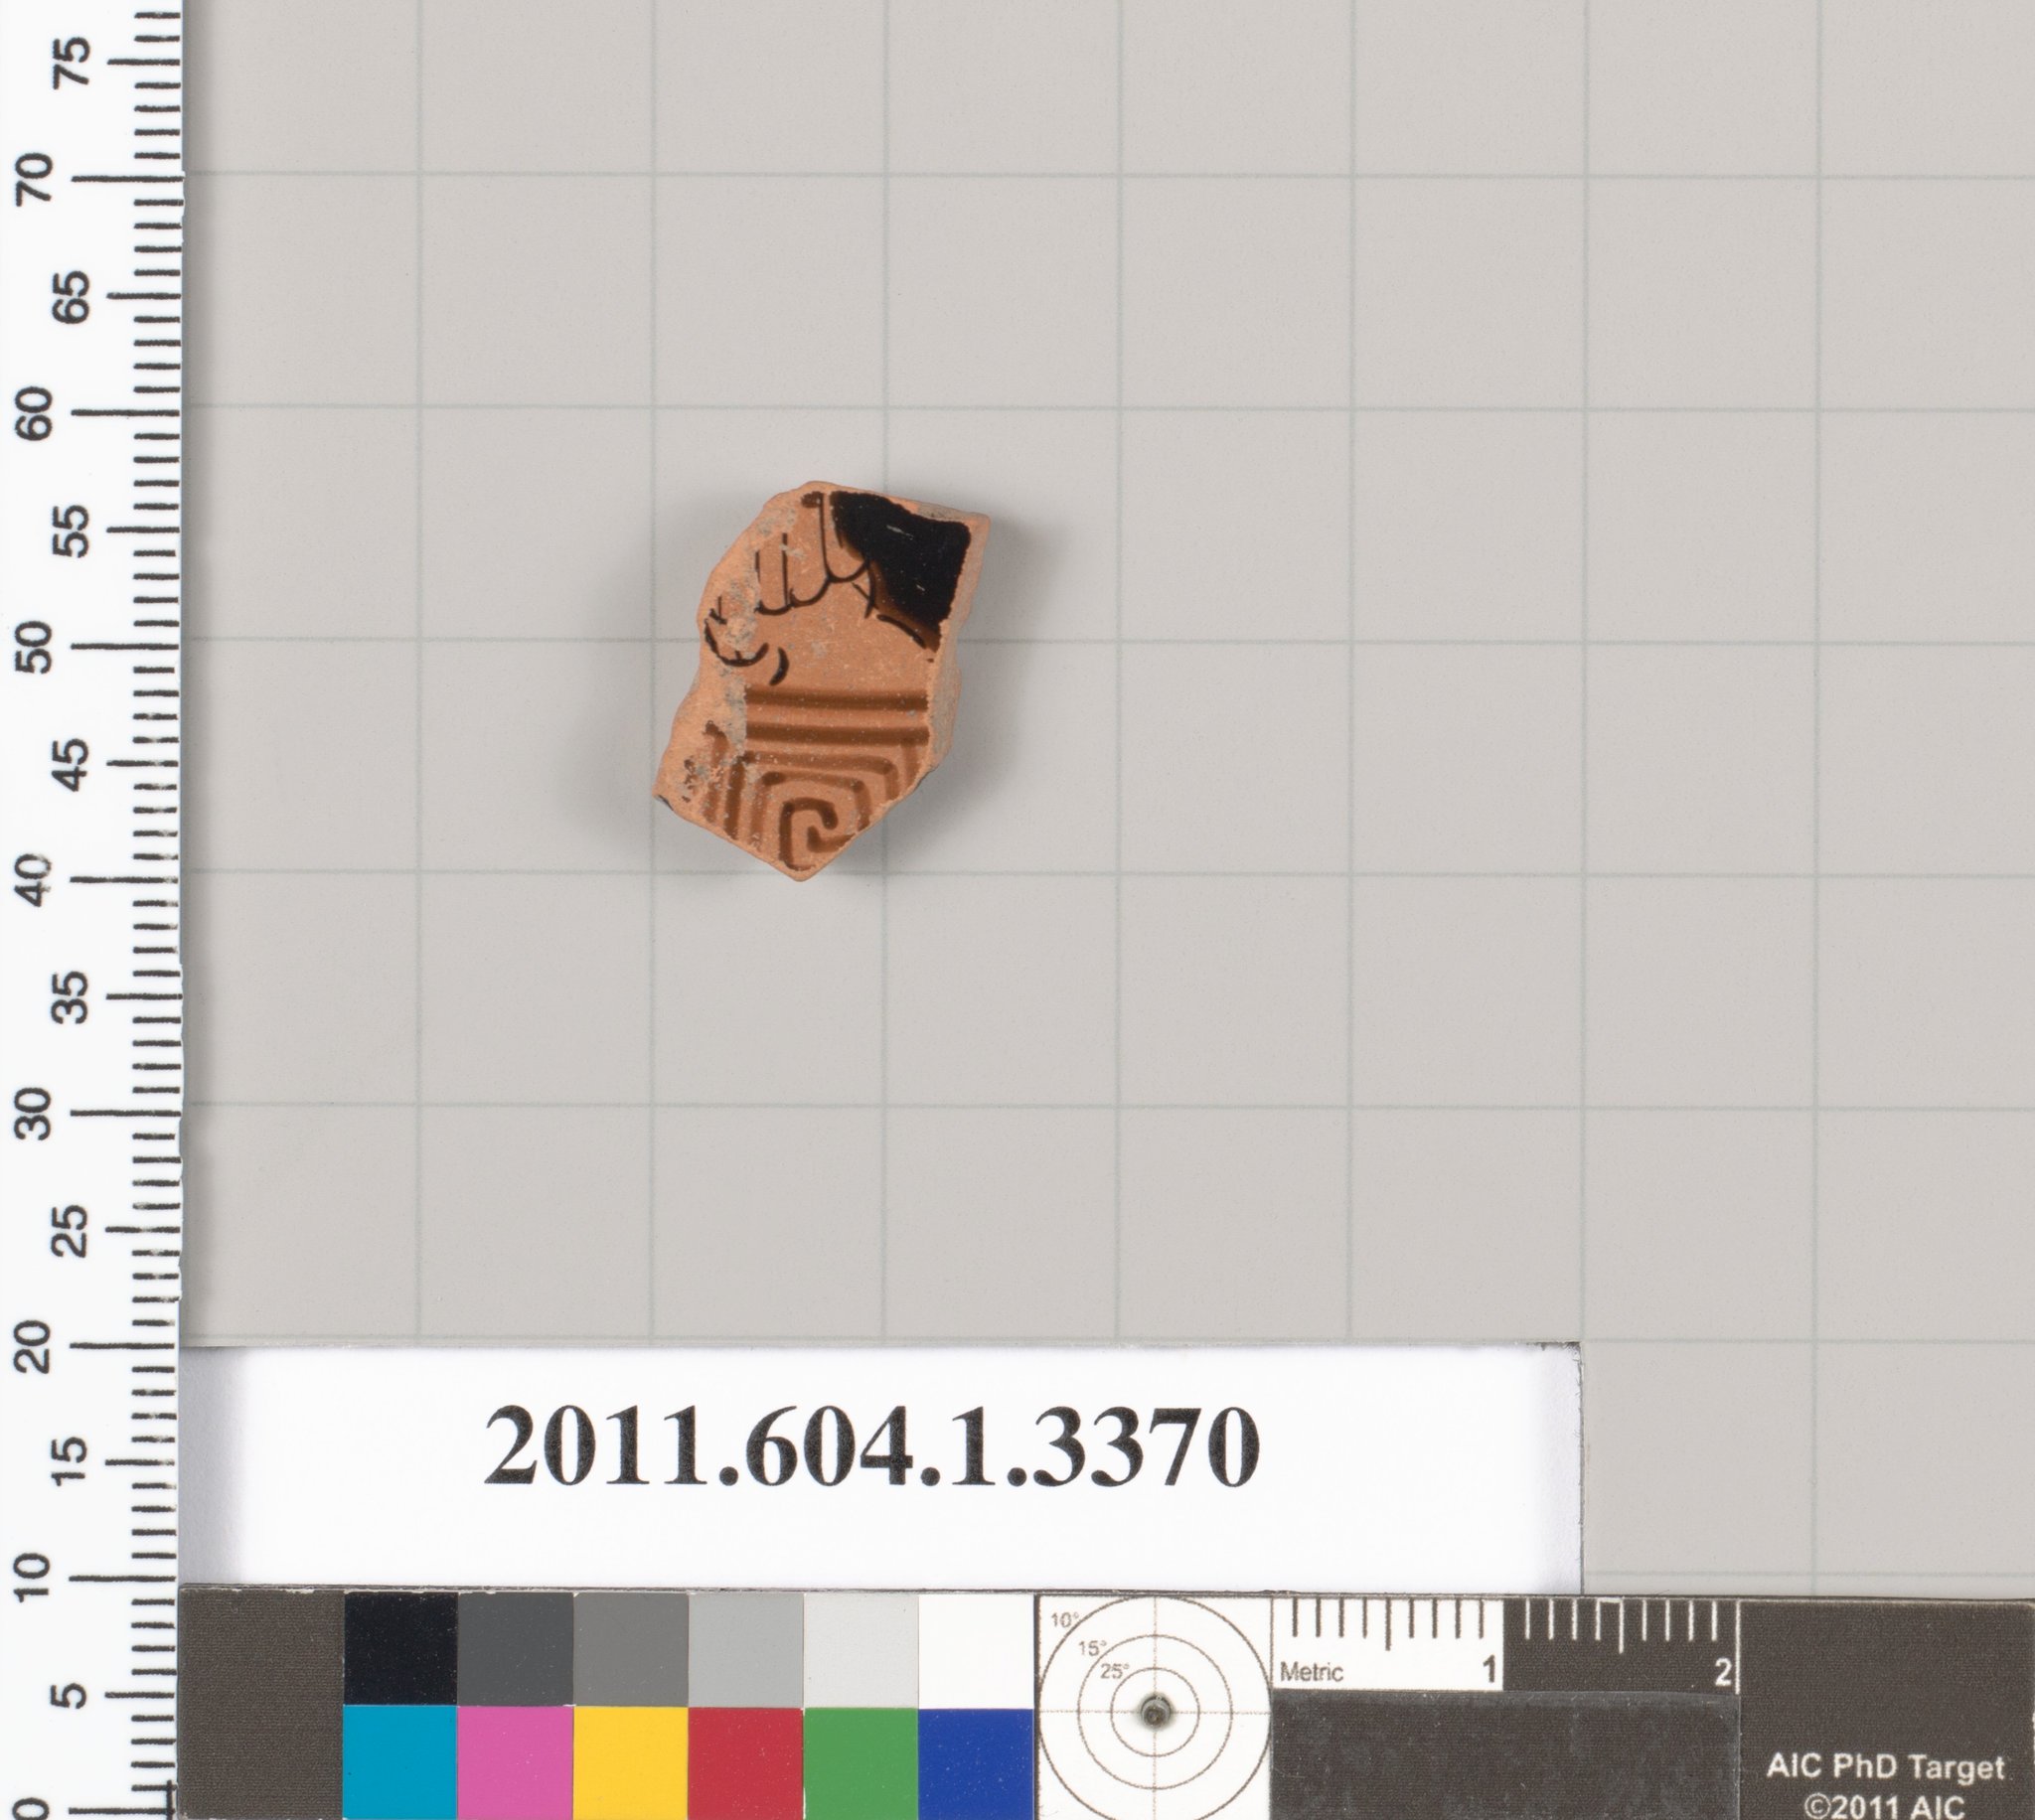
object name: kylix fragment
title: Terracotta fragment of a kylix (drinking cup)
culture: greek, attic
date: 475-451 BCE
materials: terracotta